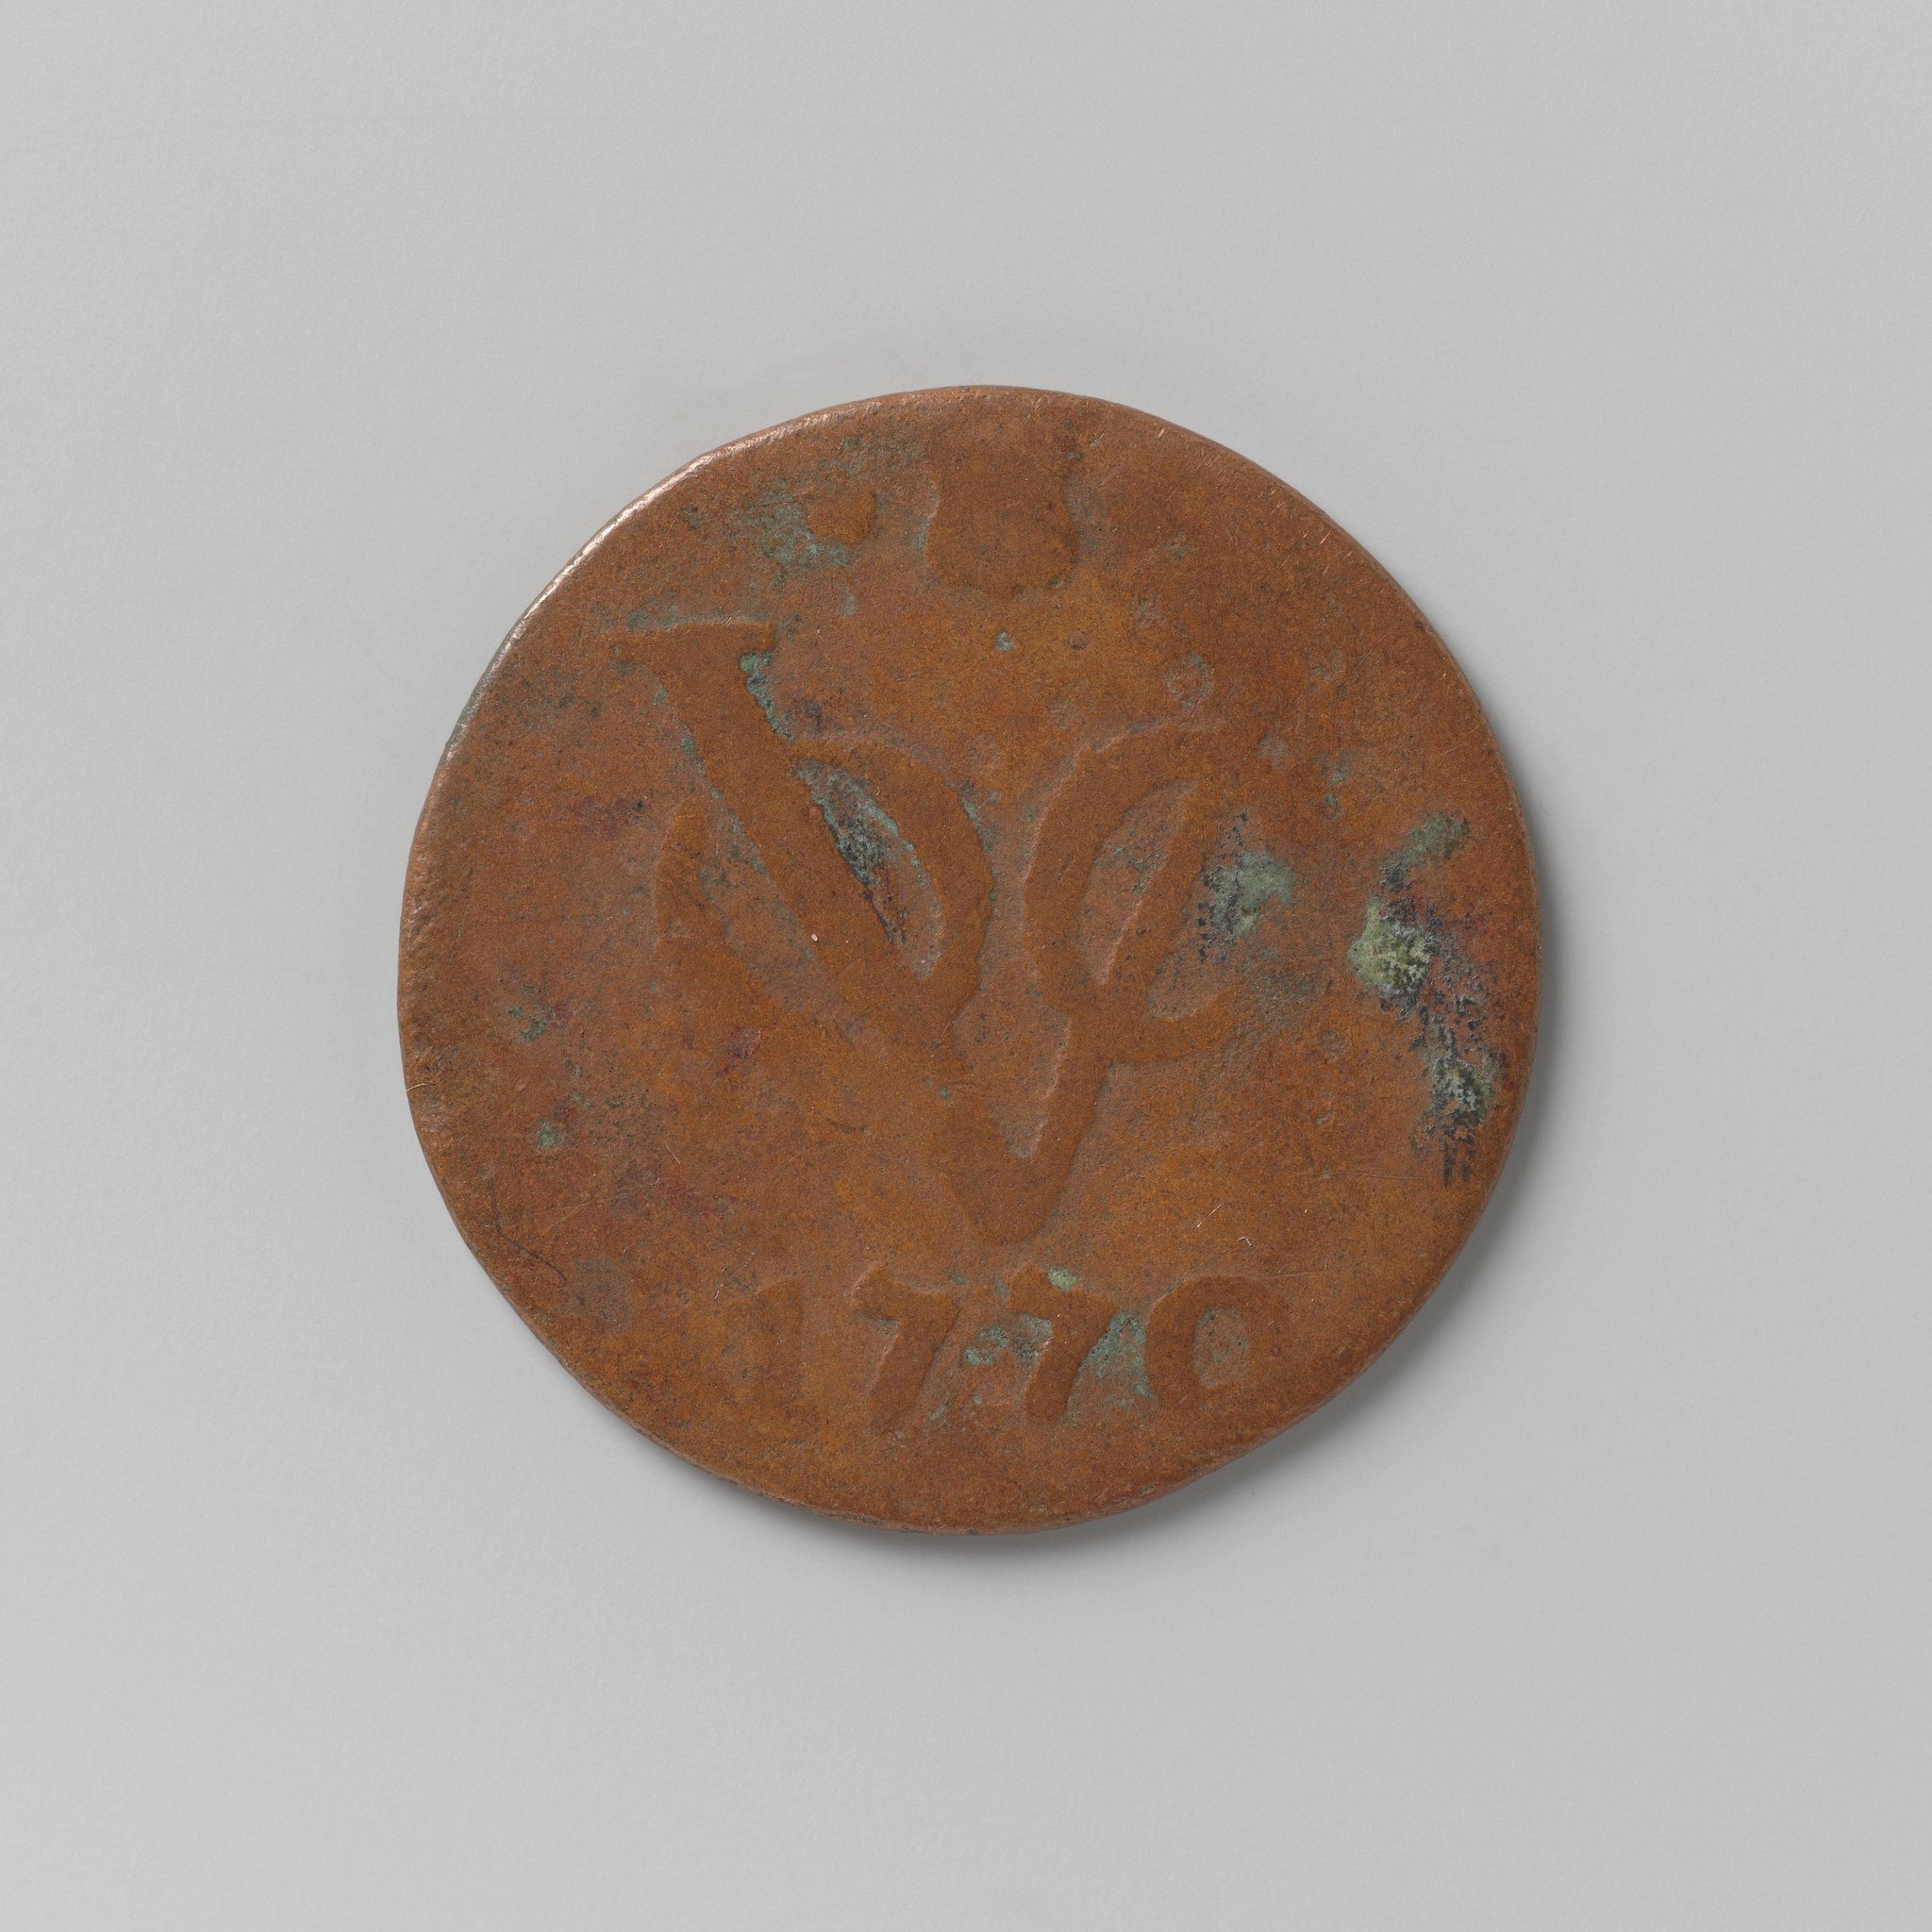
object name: coin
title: ½ duit van de VOC uit de stad Utrecht,1770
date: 1770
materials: copper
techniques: striking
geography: utrecht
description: Koperen munt. Voorzijde: gekroond ingebogen wapenschild van de stad Utrecht. Keerzijde: monogram van de VOC, waarboven muntteken en waaronder jaartal. Gladde rand.